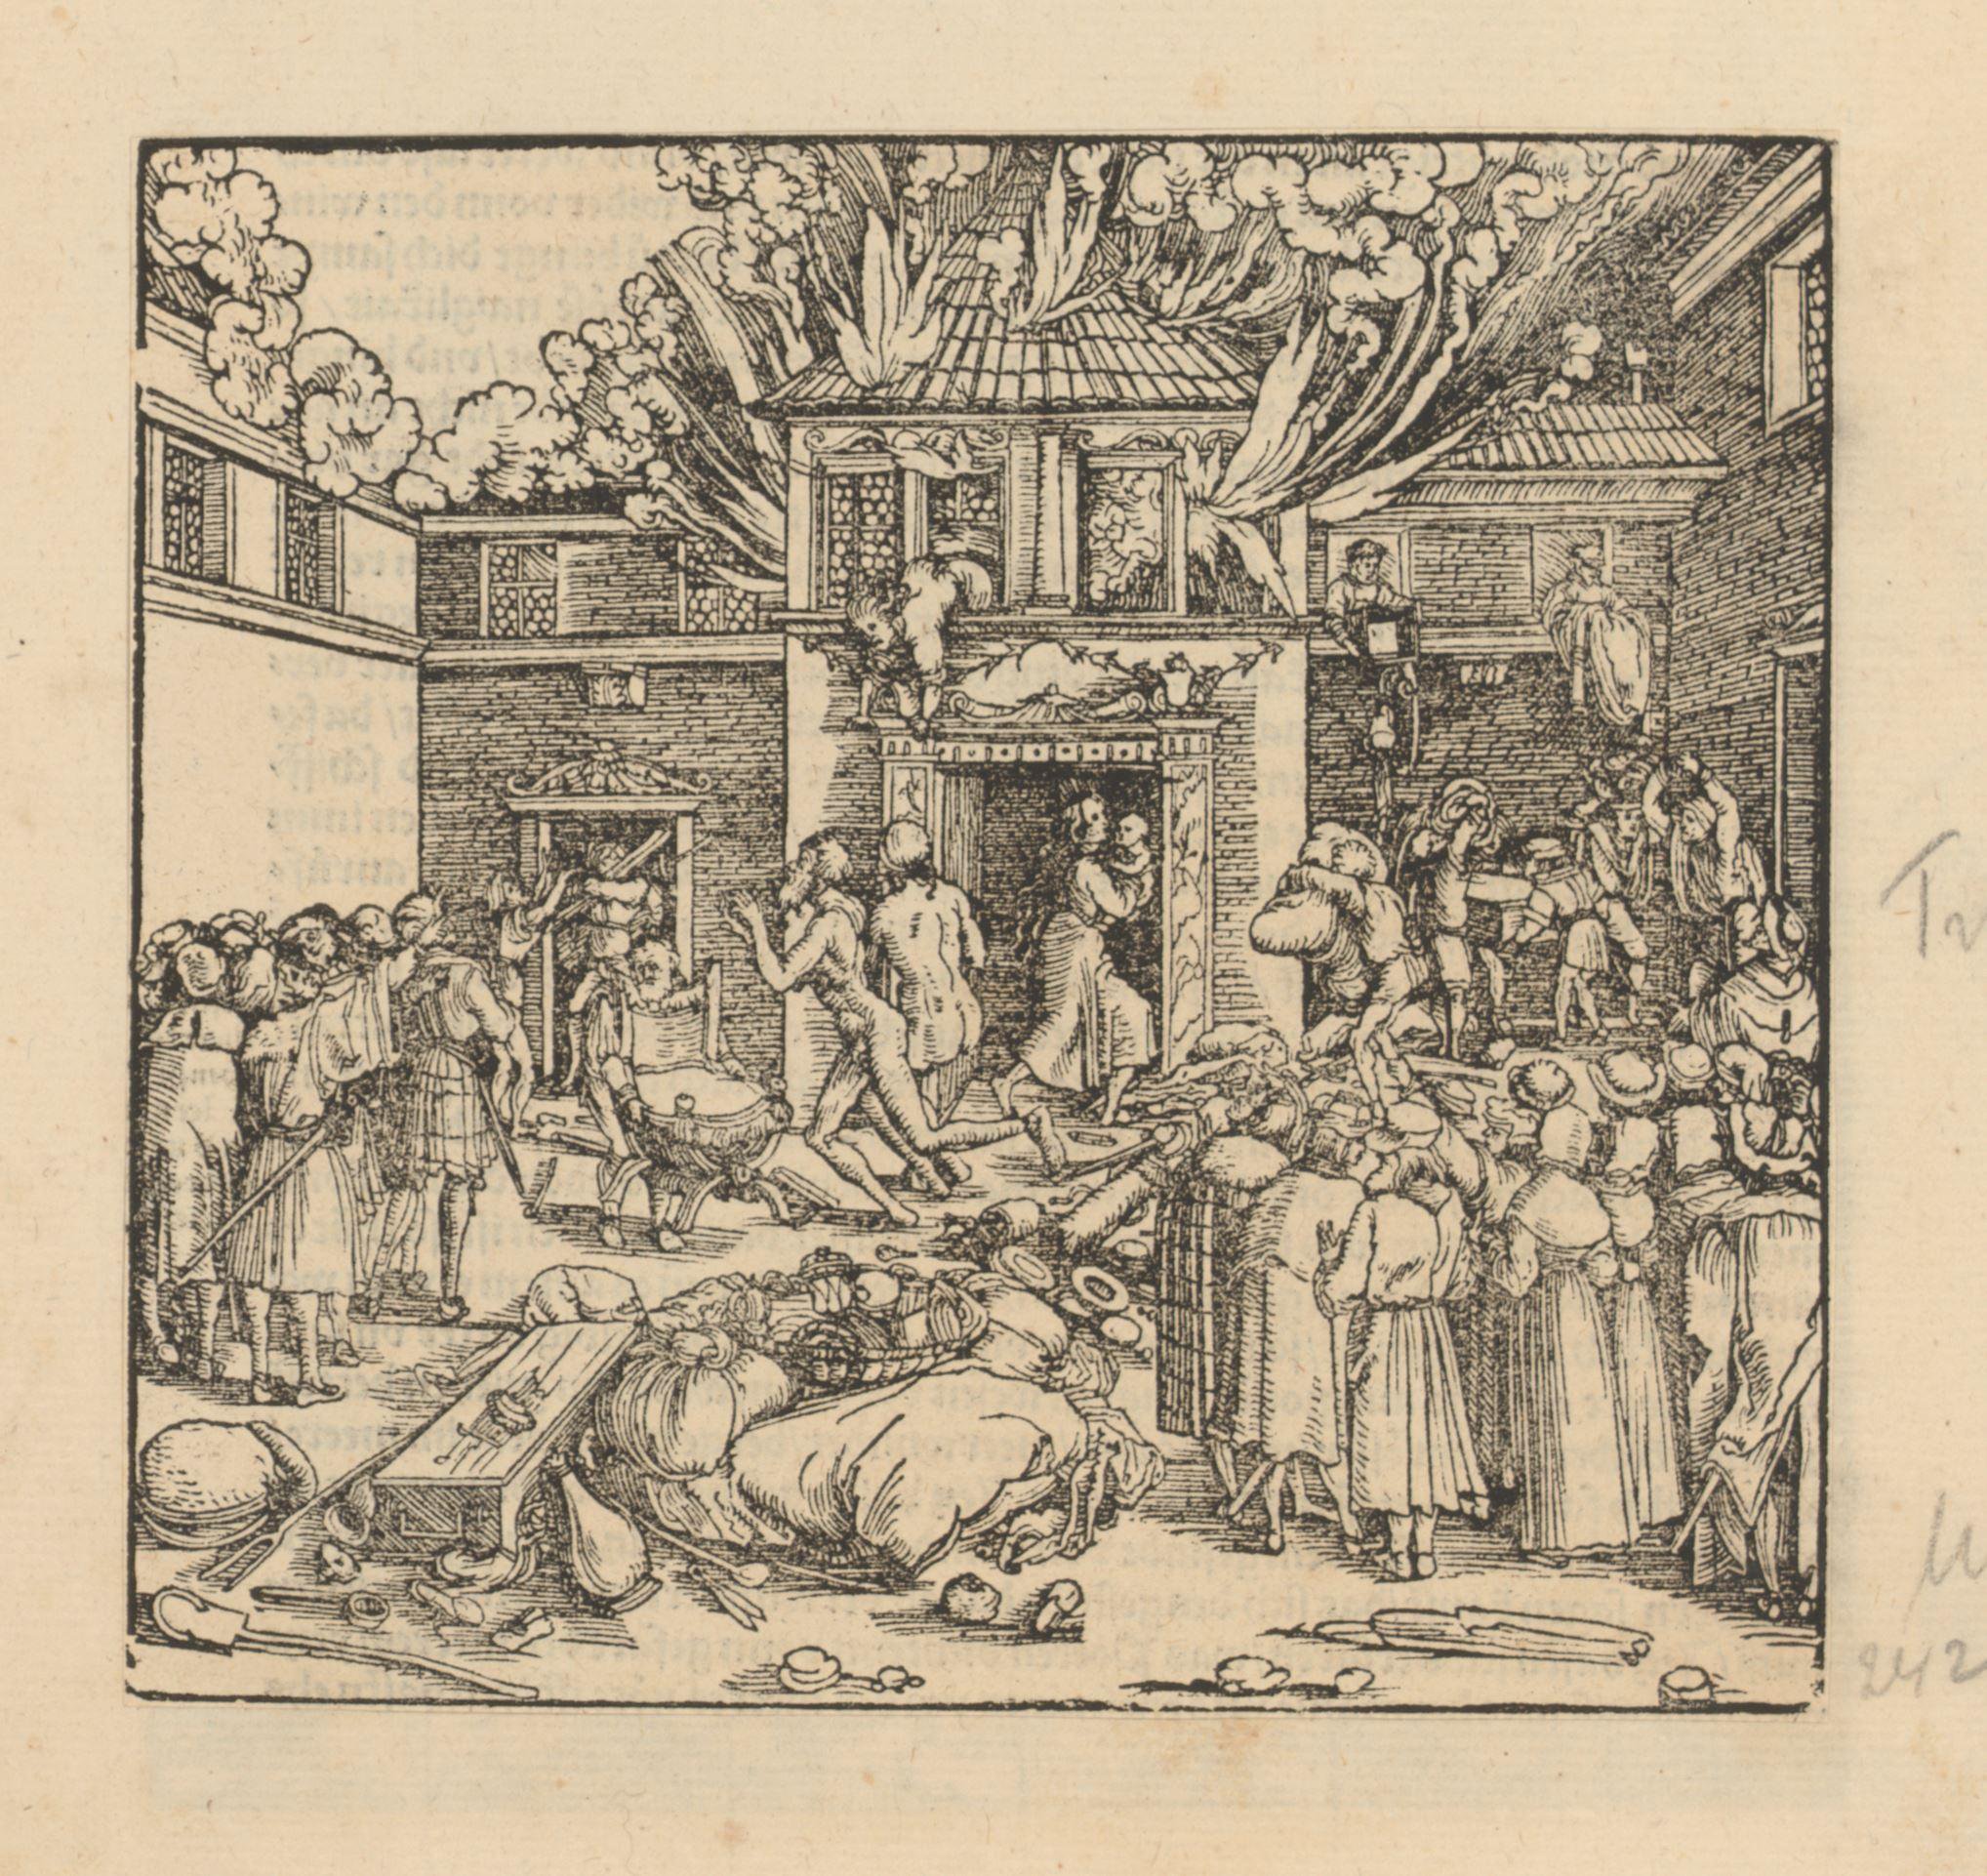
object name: album leaf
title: Grote brand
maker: Anonymous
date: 1514-1532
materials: paper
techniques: letterpress printing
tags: fire-fighting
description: Deze prent is gebruikt in: Petrarca, Francesco. Von der Artzney bayder Glück, des guten und widerwertigen: unnd weß sich ain yeder inn Gelück und Unglück halten sol (...). Augsburg: Heinrich Steiner, 1532. Deze uitgave is ook bekend onder de titel 'Trostspiegel in Glück und Unglück'.